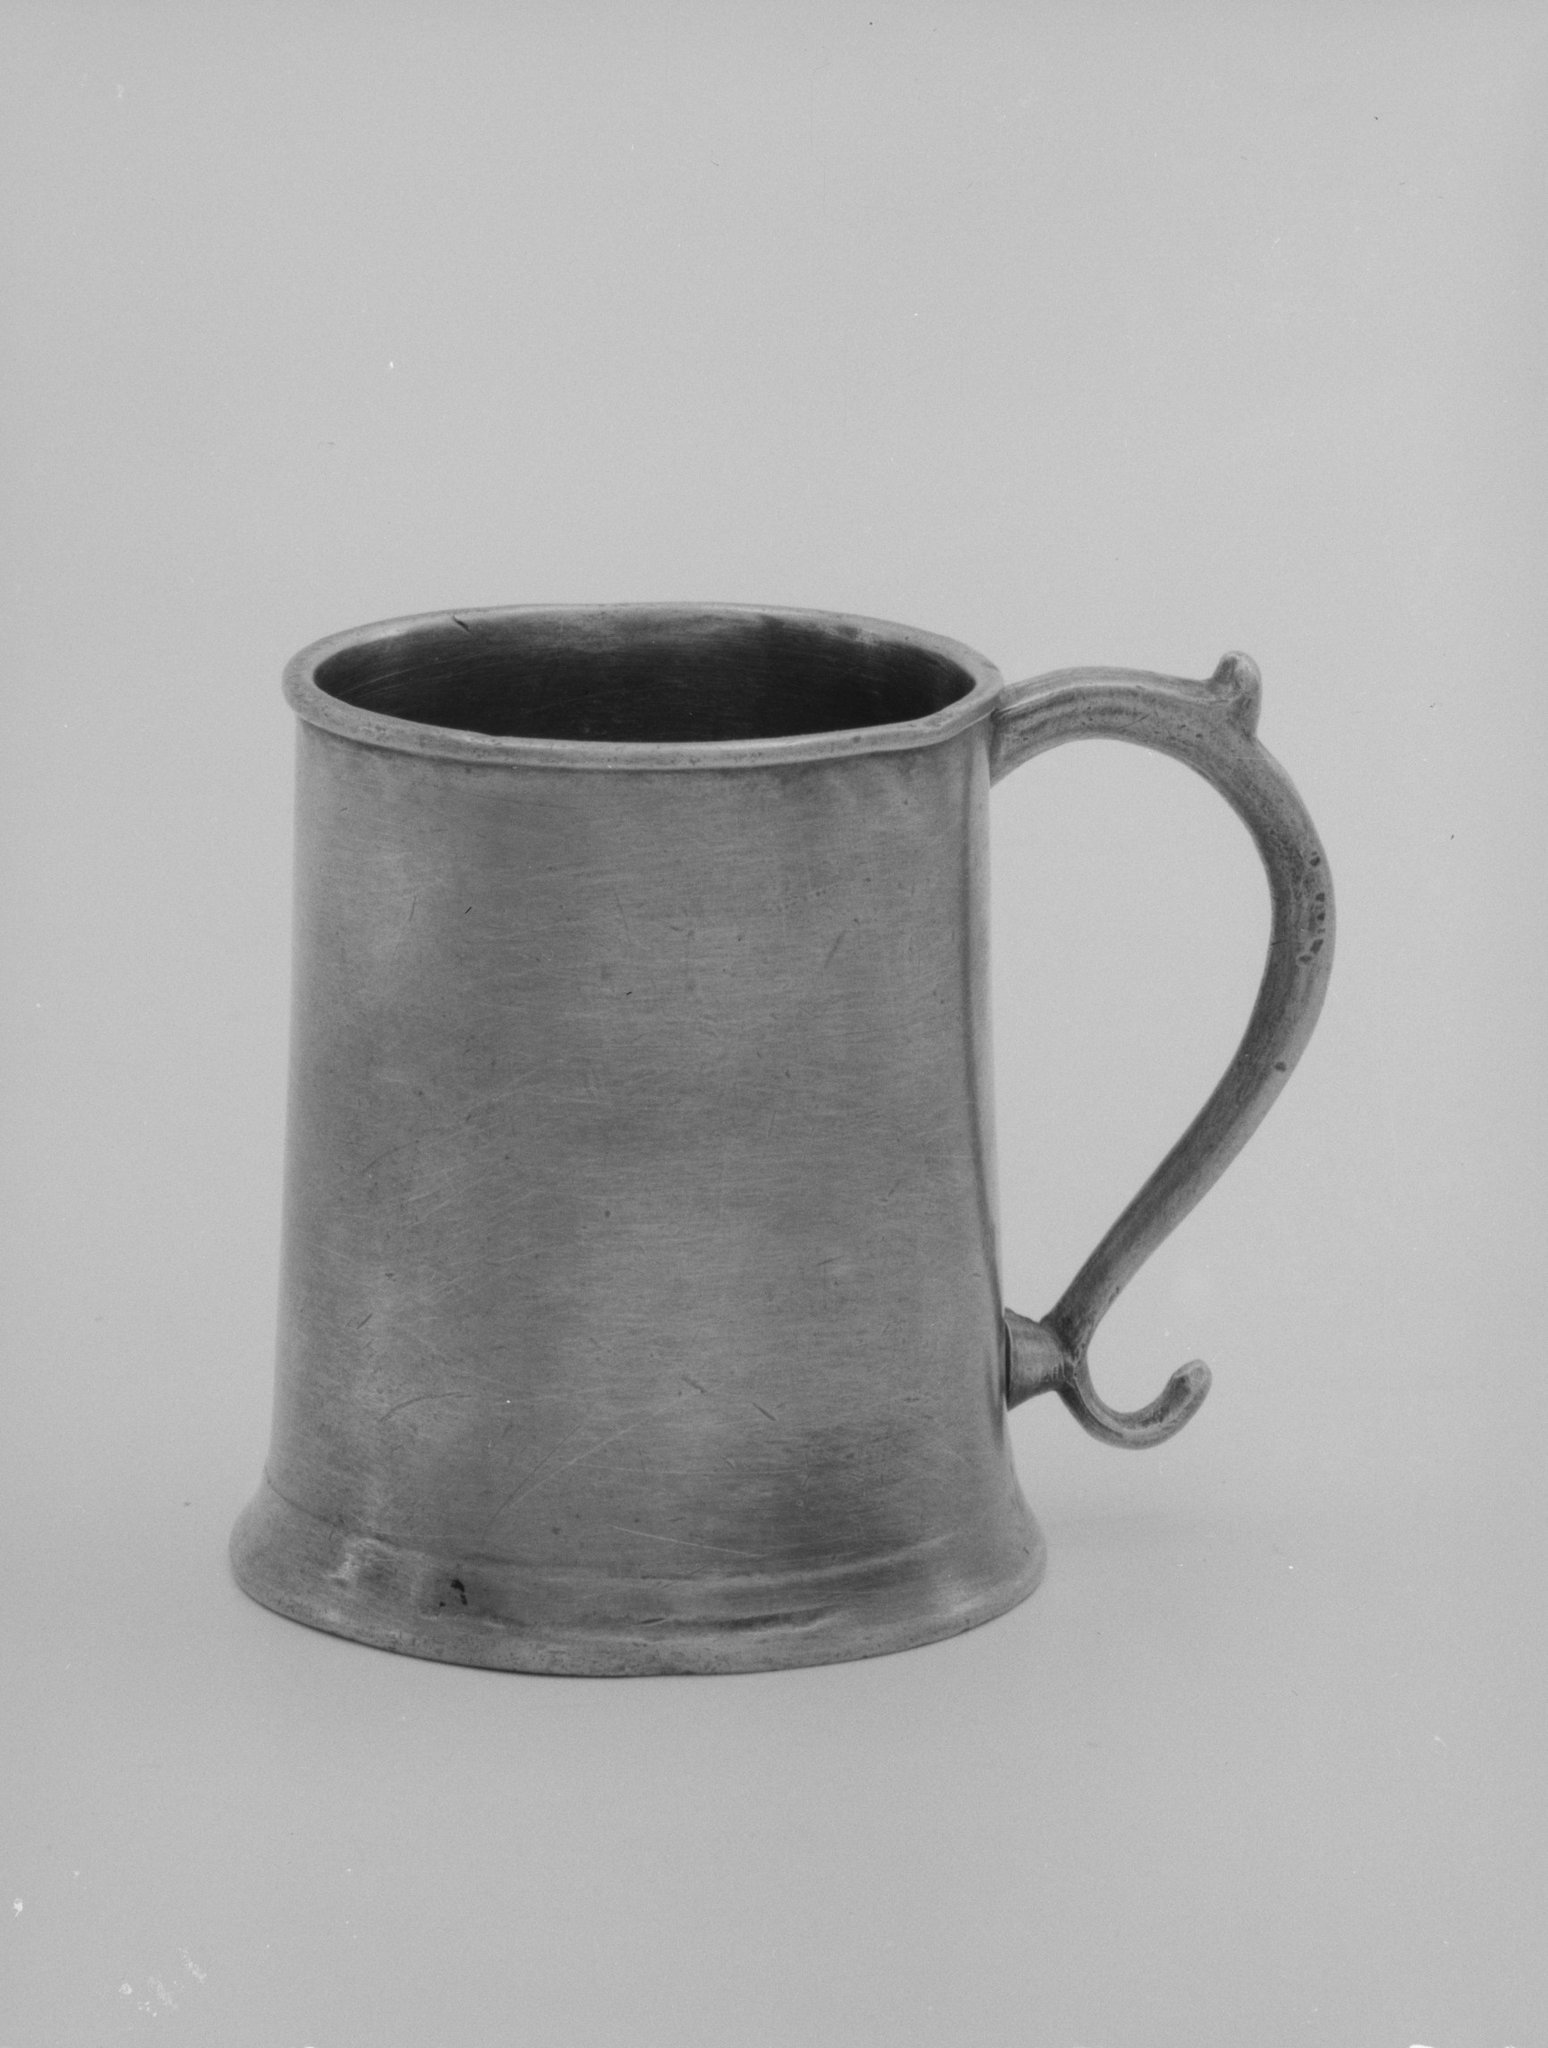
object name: mug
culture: american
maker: samuel danforth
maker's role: maker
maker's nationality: american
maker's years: 1774-1816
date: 1795-1816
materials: pewter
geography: united states